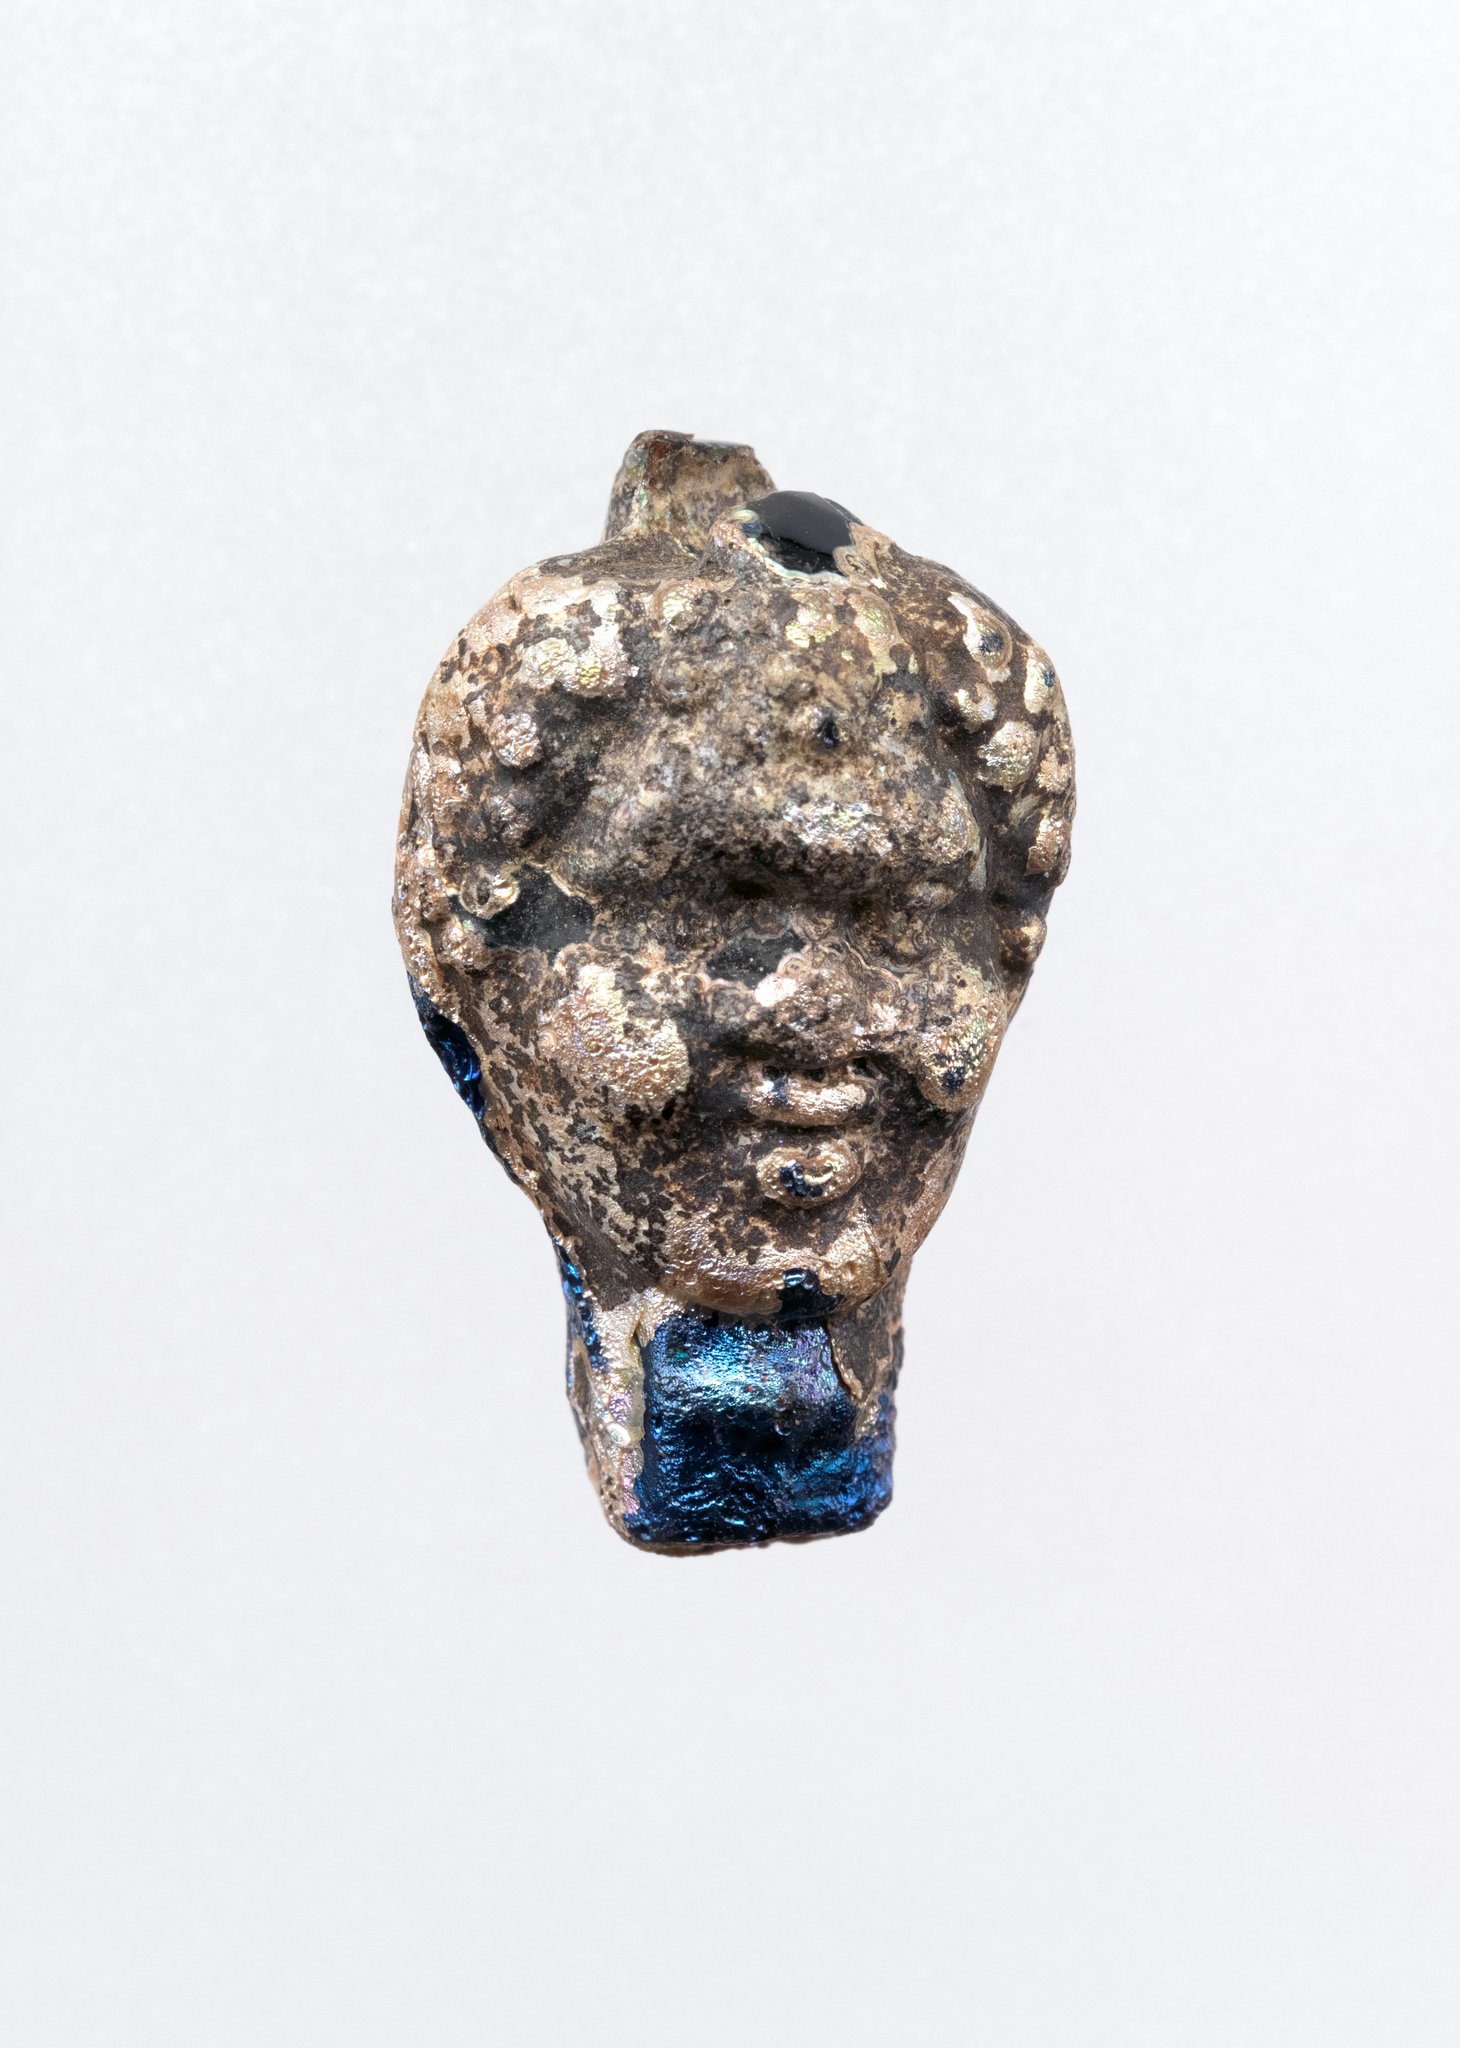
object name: head pendant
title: Glass pendant in the shape of a Black African's head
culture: greek, eastern mediterranean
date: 134-1 BCE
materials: glass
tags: heads